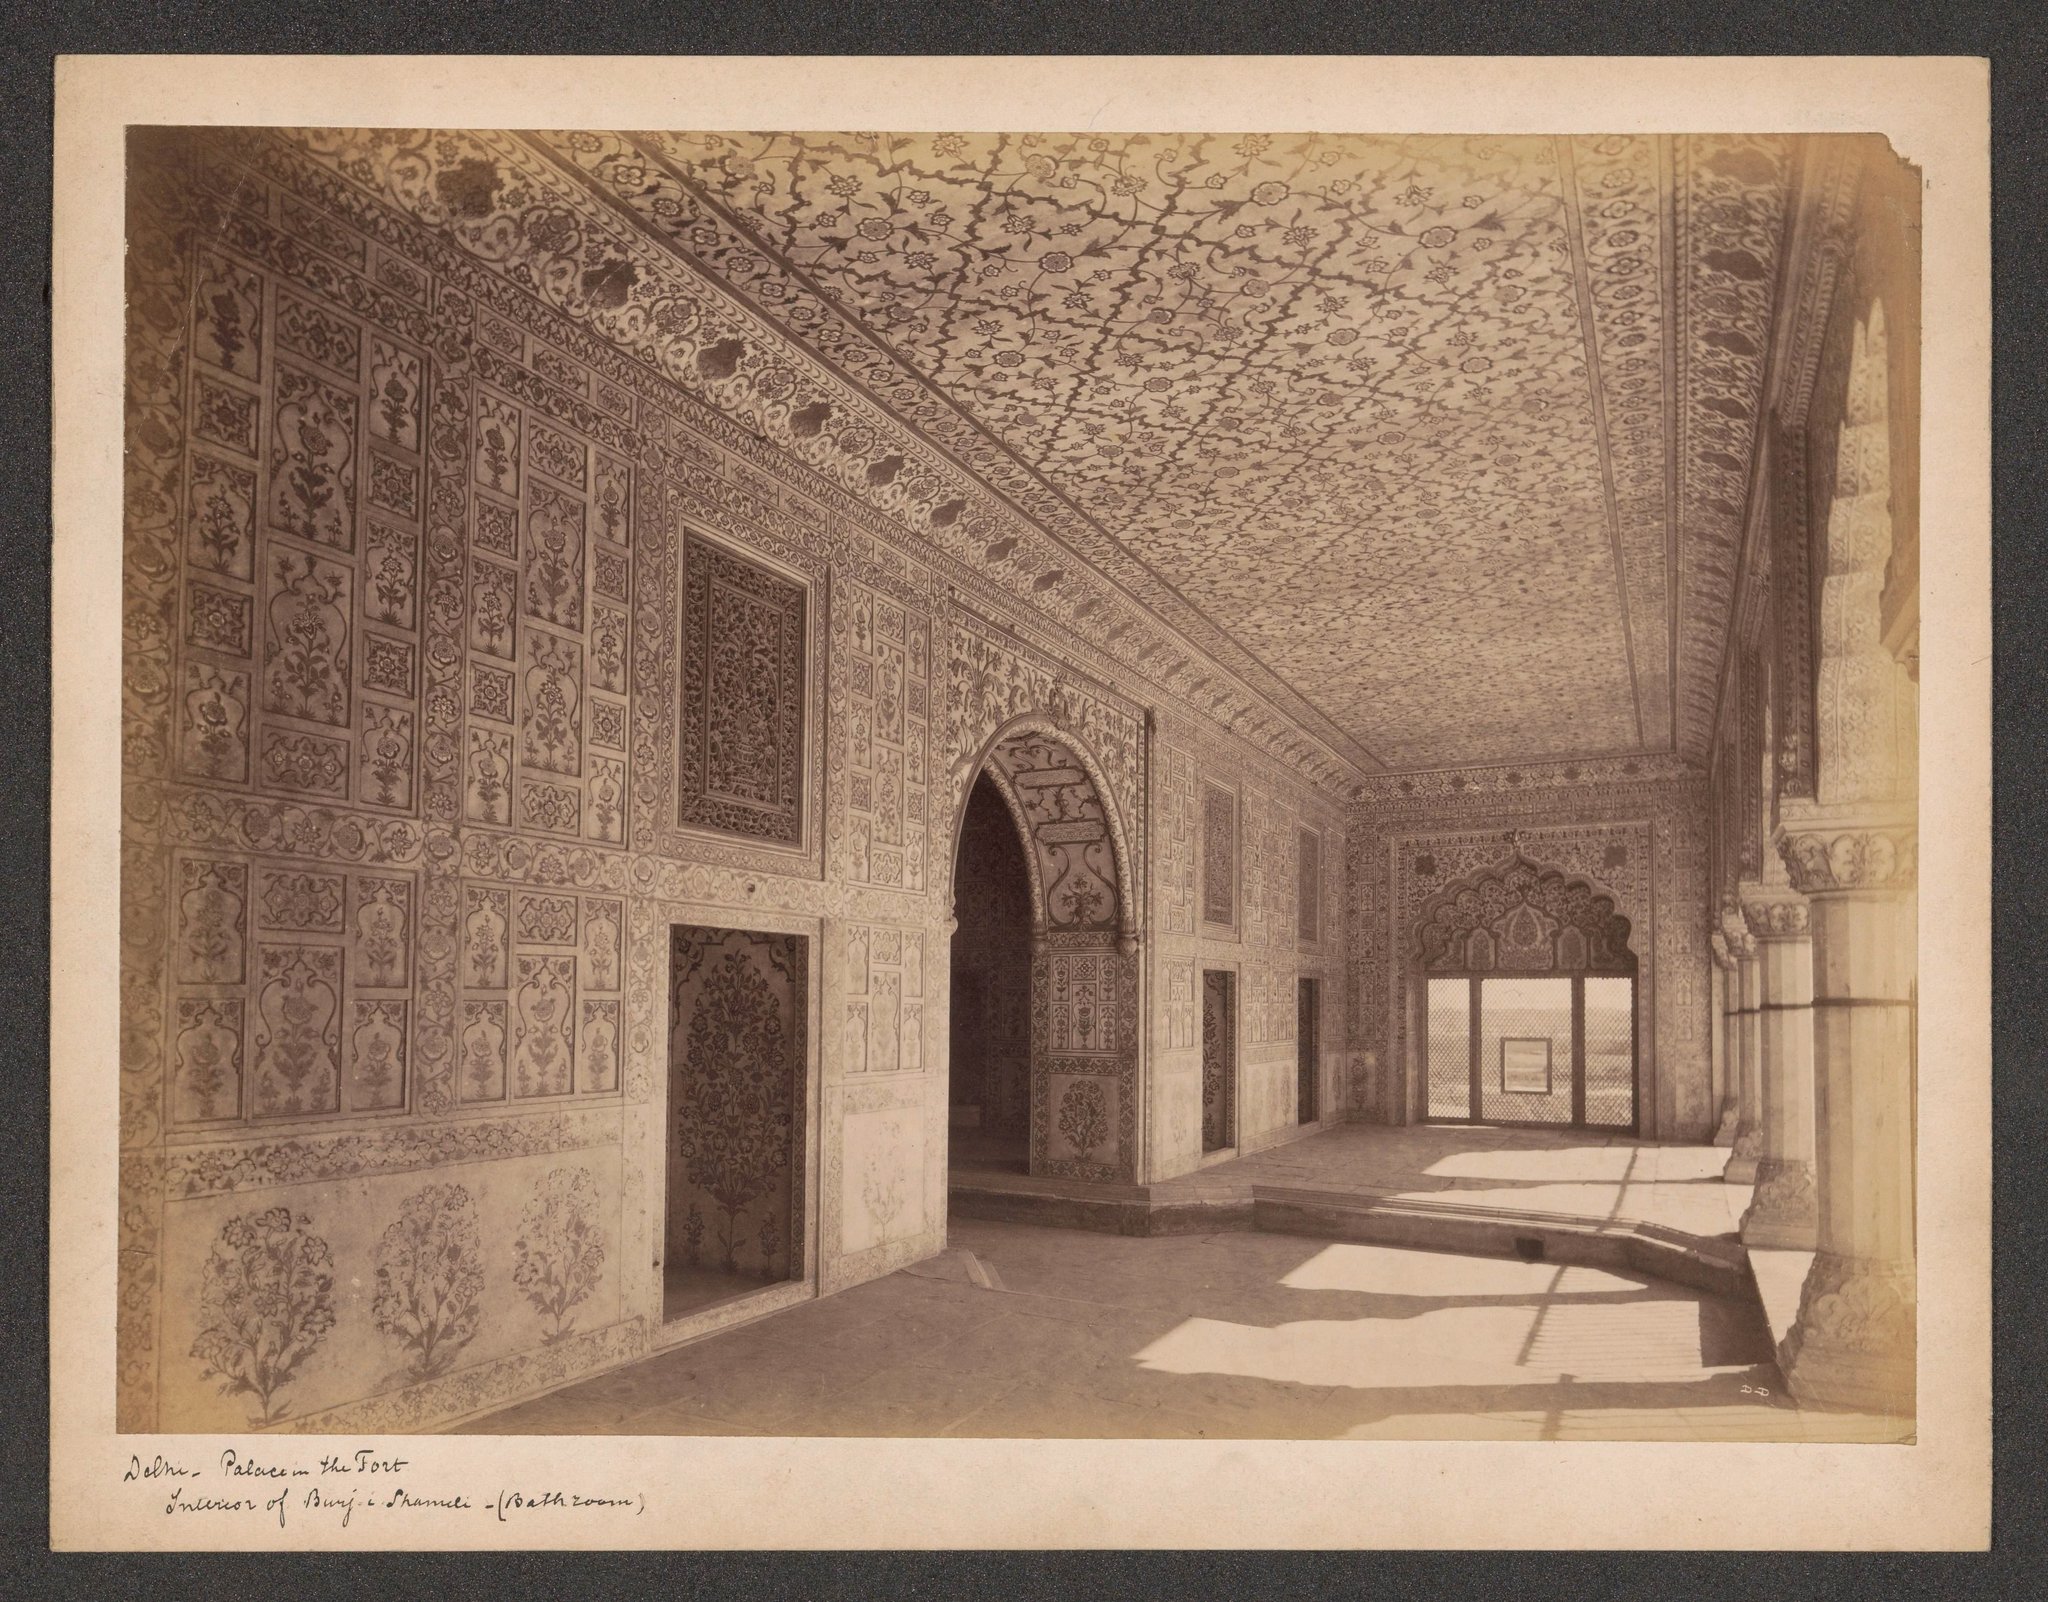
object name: photograph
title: Gallery in the Shahi Tower in the Red Fort, Delhi, India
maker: lala deen dayal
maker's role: fotograaf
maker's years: 1844-1910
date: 1868-1900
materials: cardboard, paper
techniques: albumen print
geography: delhi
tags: palace, gallery (spacious corridor)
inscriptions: inscription: ‘Lala Deen Dayal’, number: ‘68’, title: ‘Delhi - Palace in the Fort/ Interior of Burj-i-Shanuli - (Bathroom)’